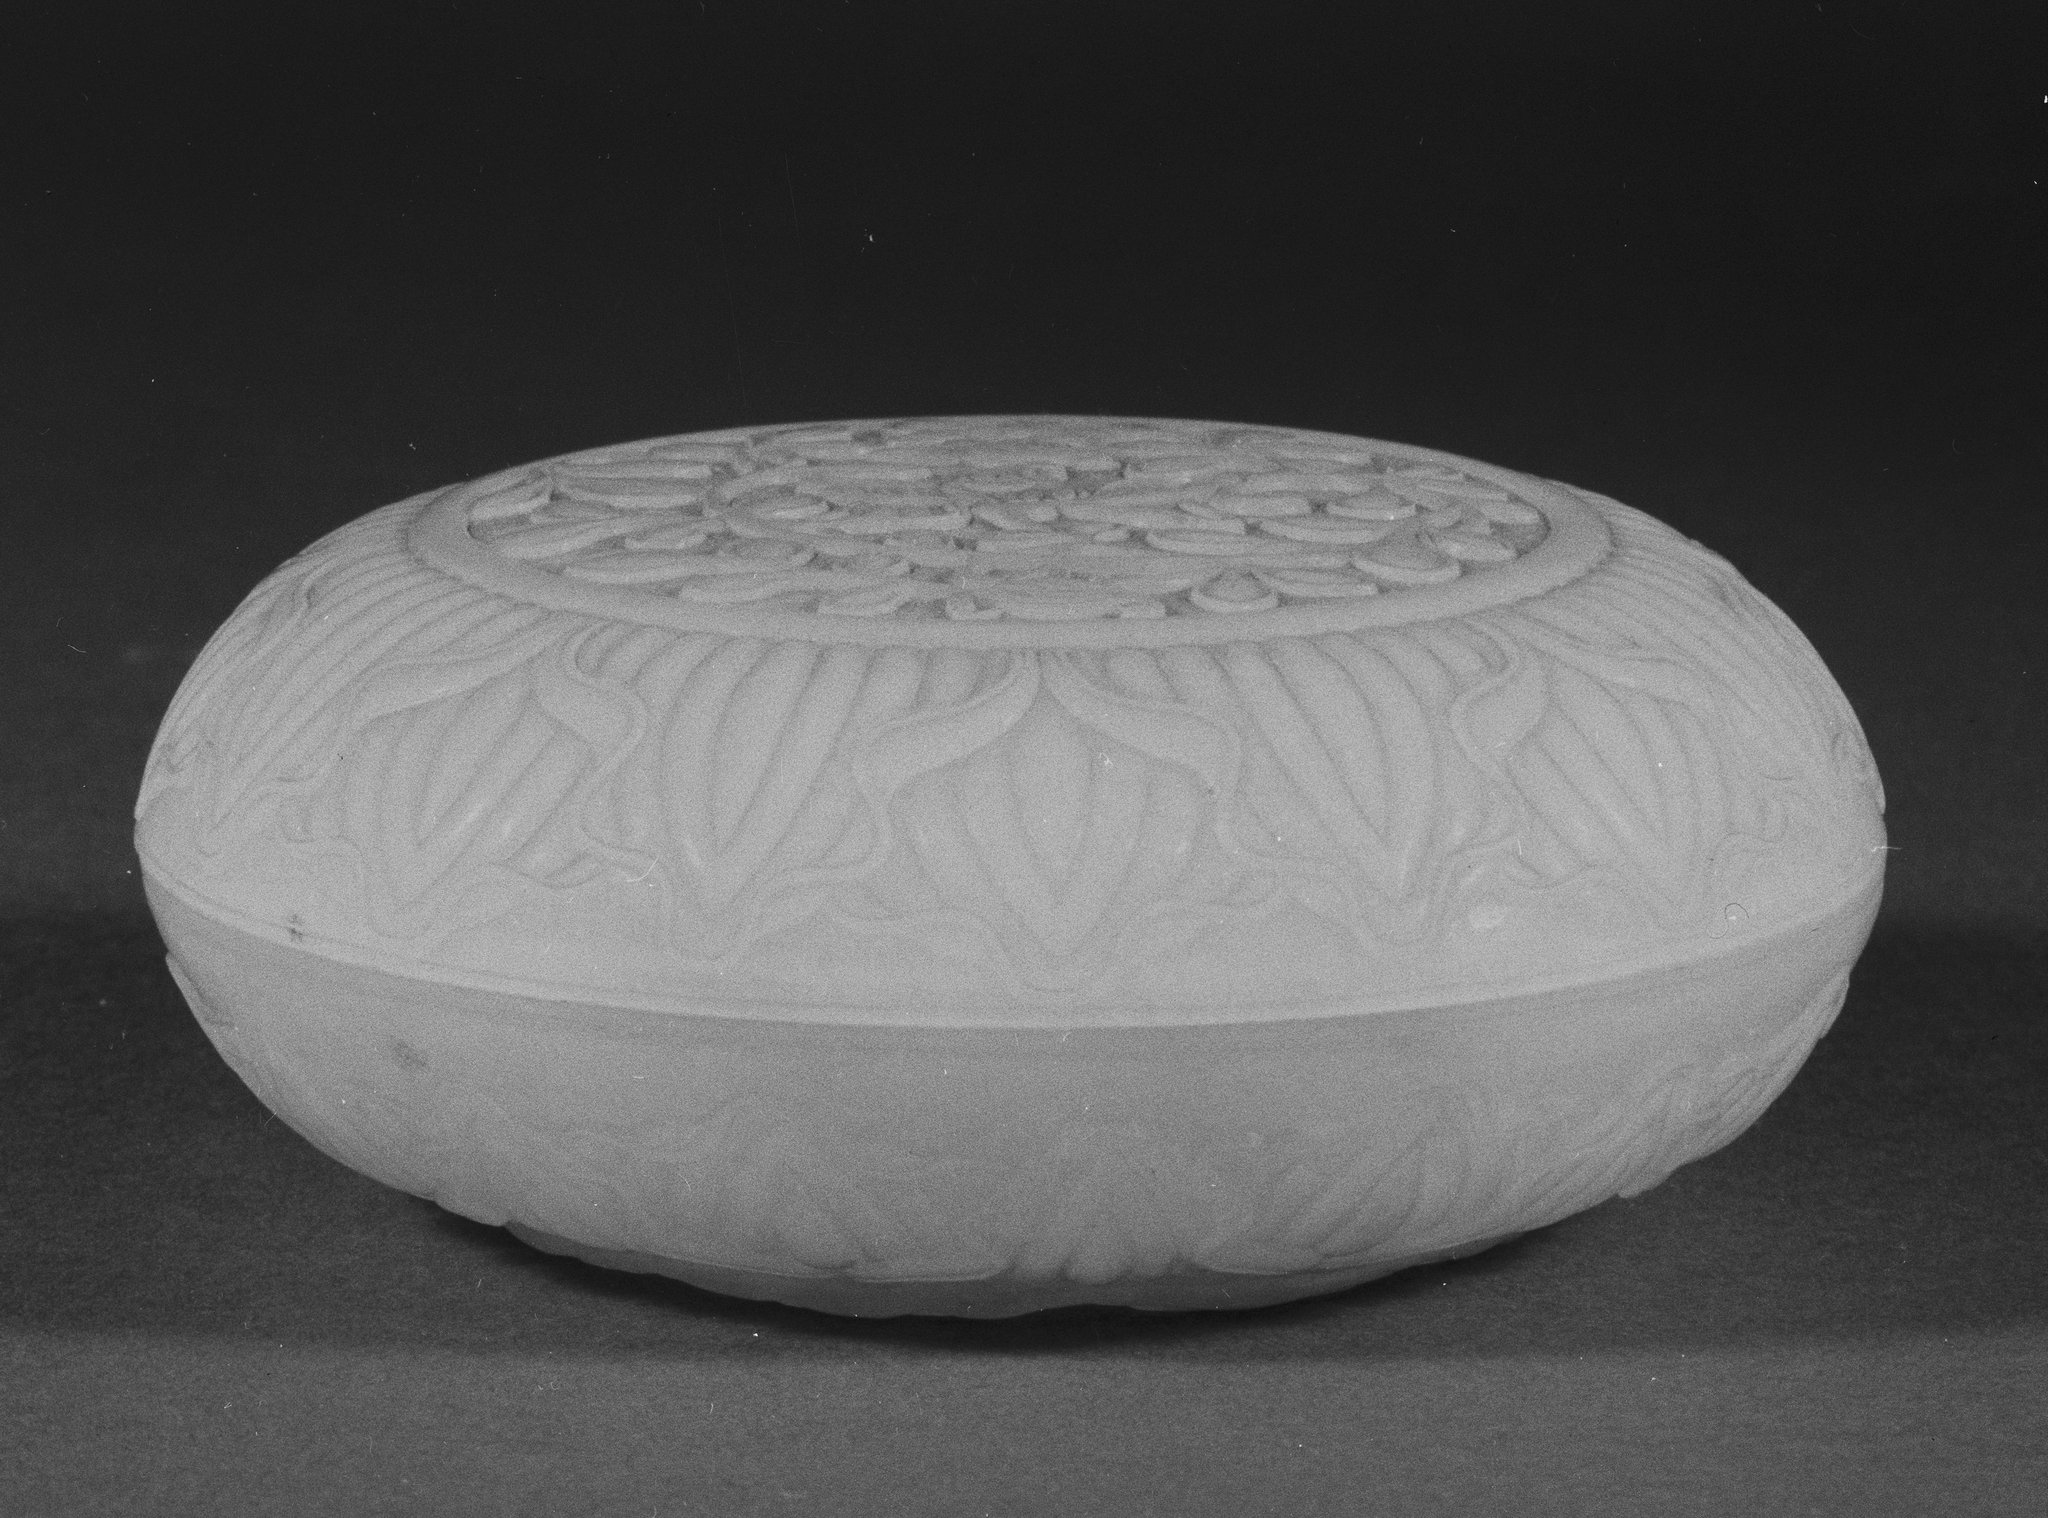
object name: covered box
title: Covered box with floral design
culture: chinese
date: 1767-1833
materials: jade